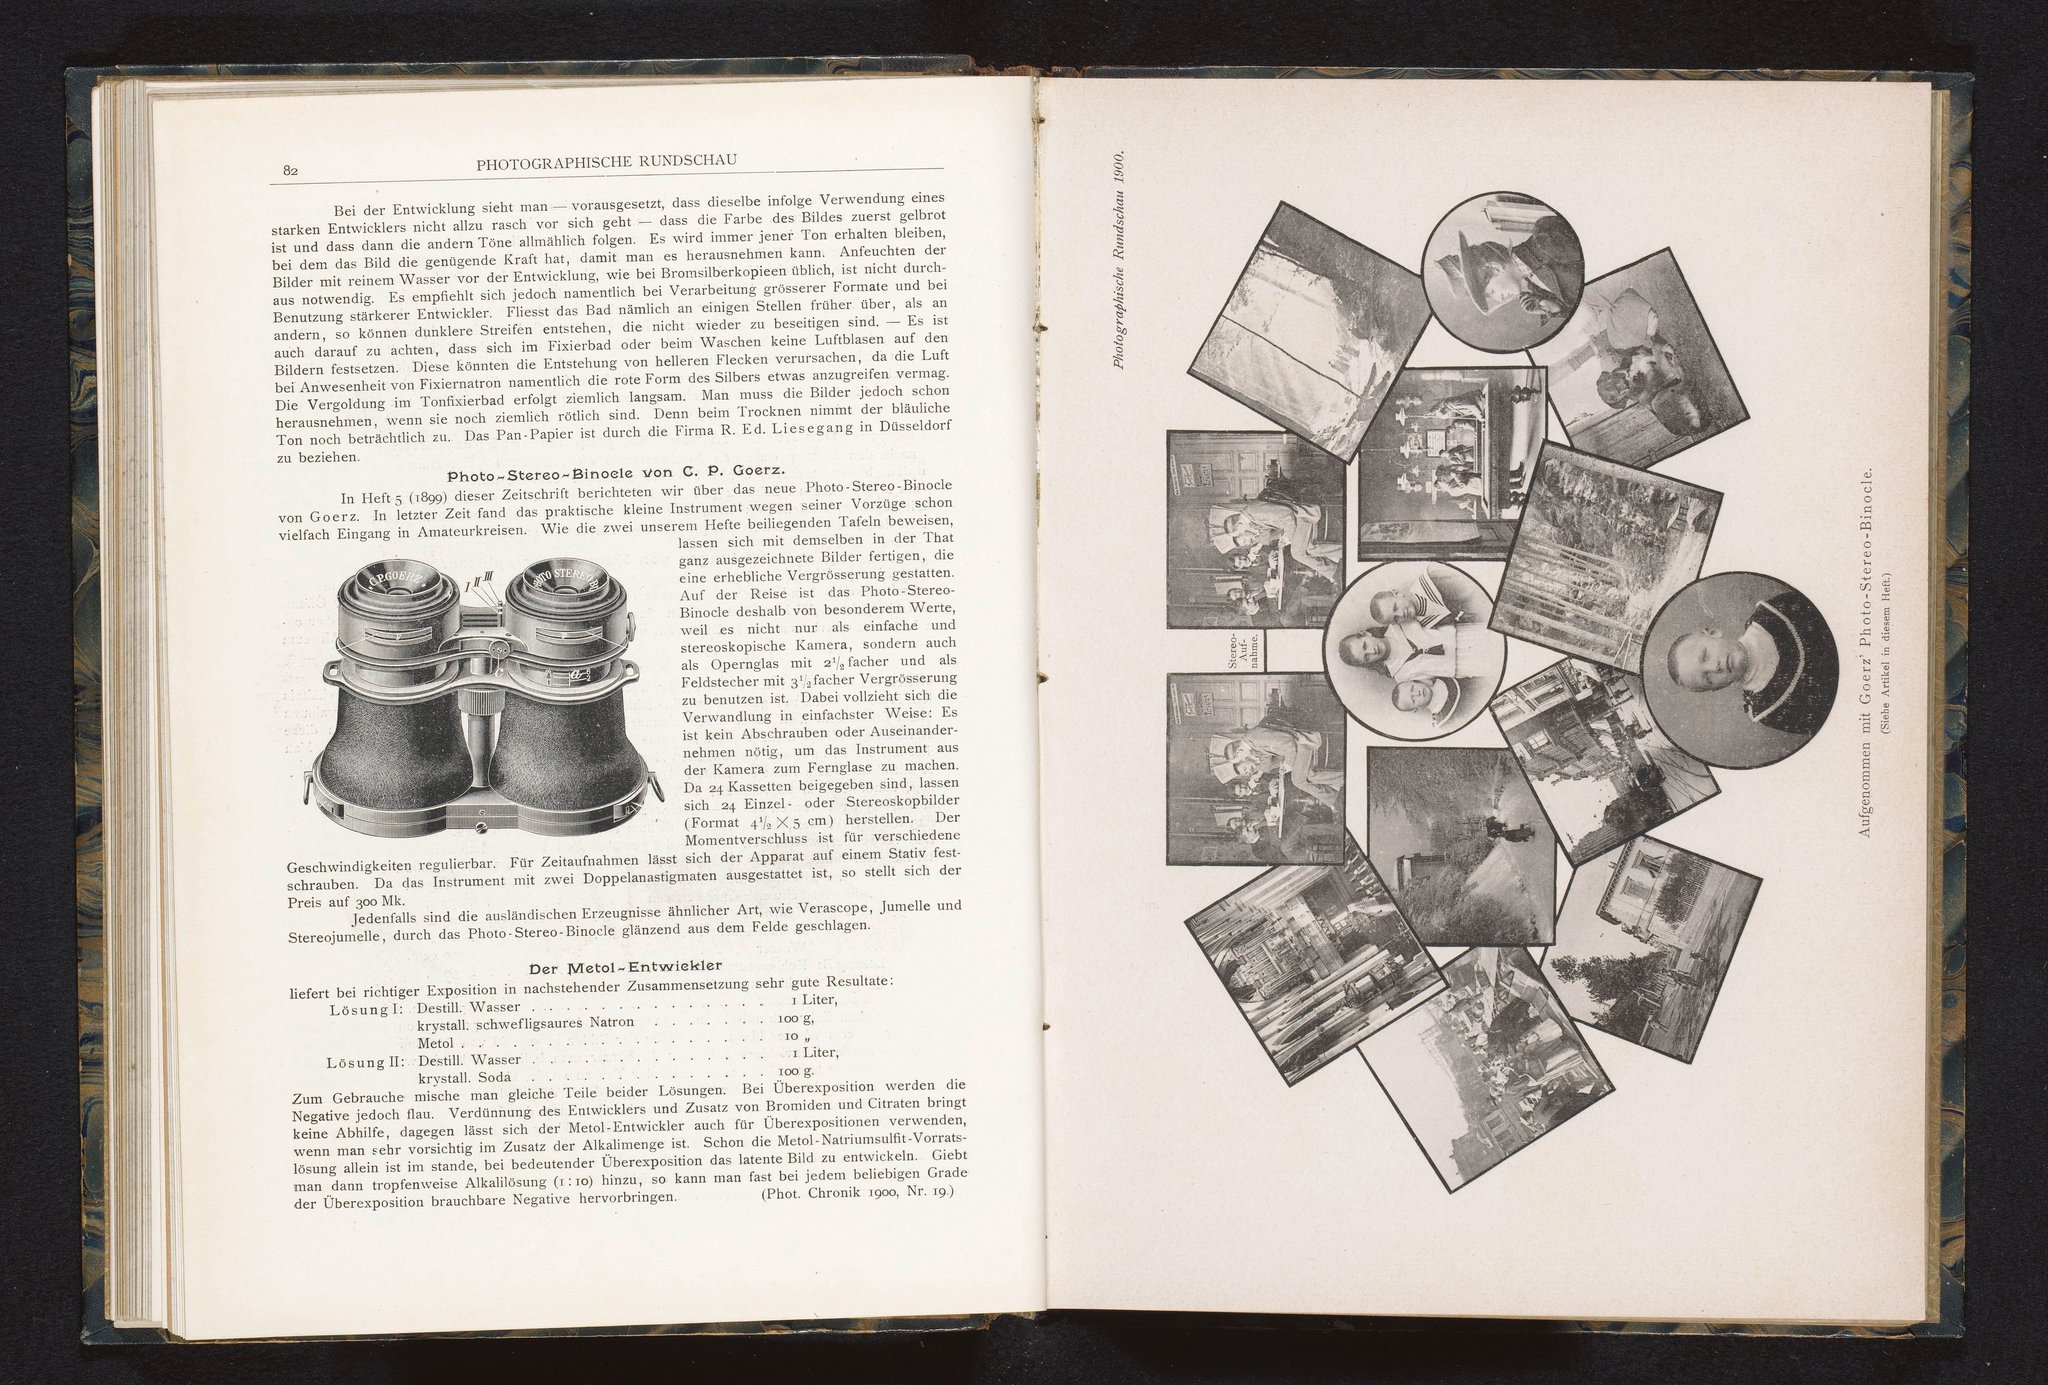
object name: photomechanical print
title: Voorbeelden van verschillende foto's, onder andere stereofoto's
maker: Anonymous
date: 1895-1900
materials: paper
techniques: lithograph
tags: historical persons not known by name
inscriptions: inscription: ‘Aufgenohmen mit Goerz' Photo-Stereo-Binocle./ (Siehe Artikel in diesem Heft.)’